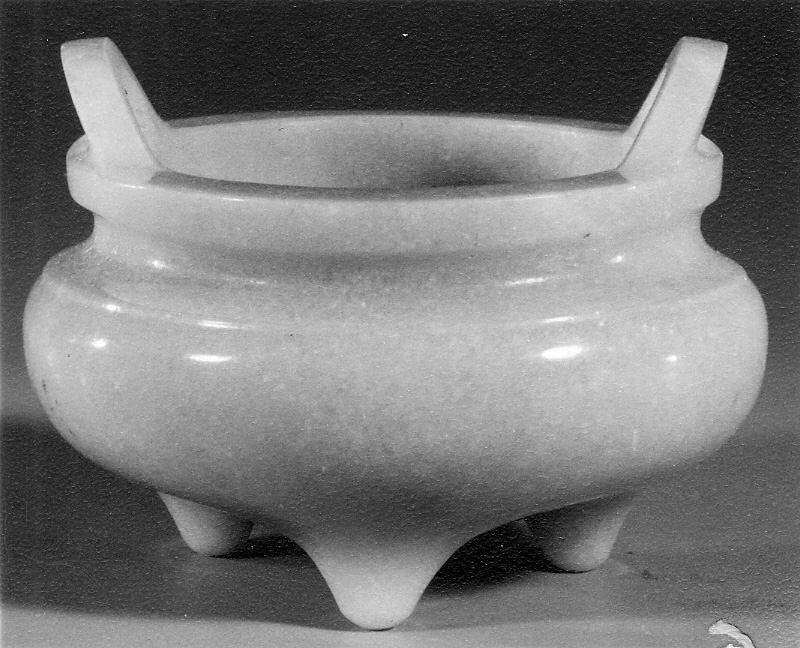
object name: caldron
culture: chinese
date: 1867-1900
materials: stone